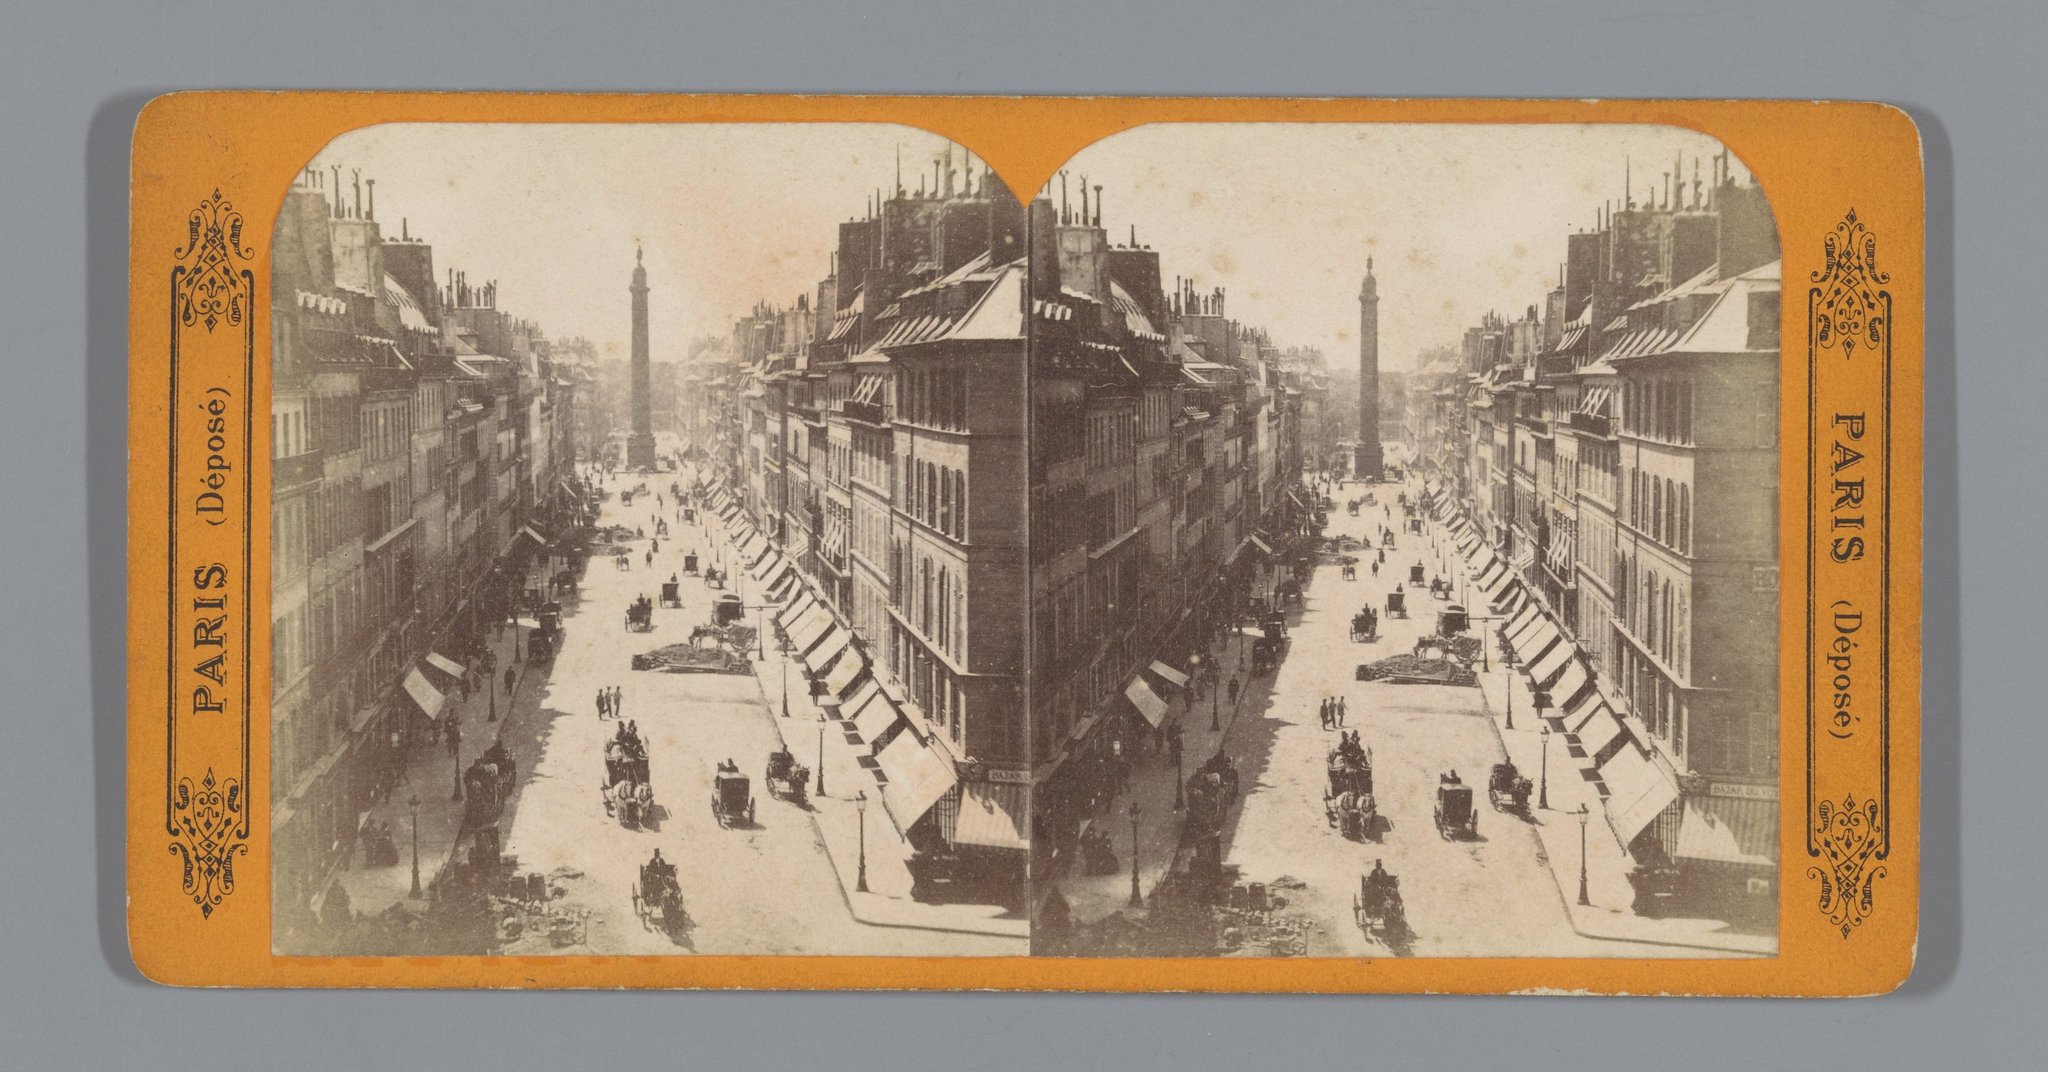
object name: stereograph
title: Paris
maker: Anonymous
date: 1860-1885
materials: cardboard, photographic support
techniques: albumen print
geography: paris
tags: triumphal column with helical friezes, street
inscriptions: inscription: ‘Colonne Vendôme’, name: ‘M. van Os Opticien Rotterdam’